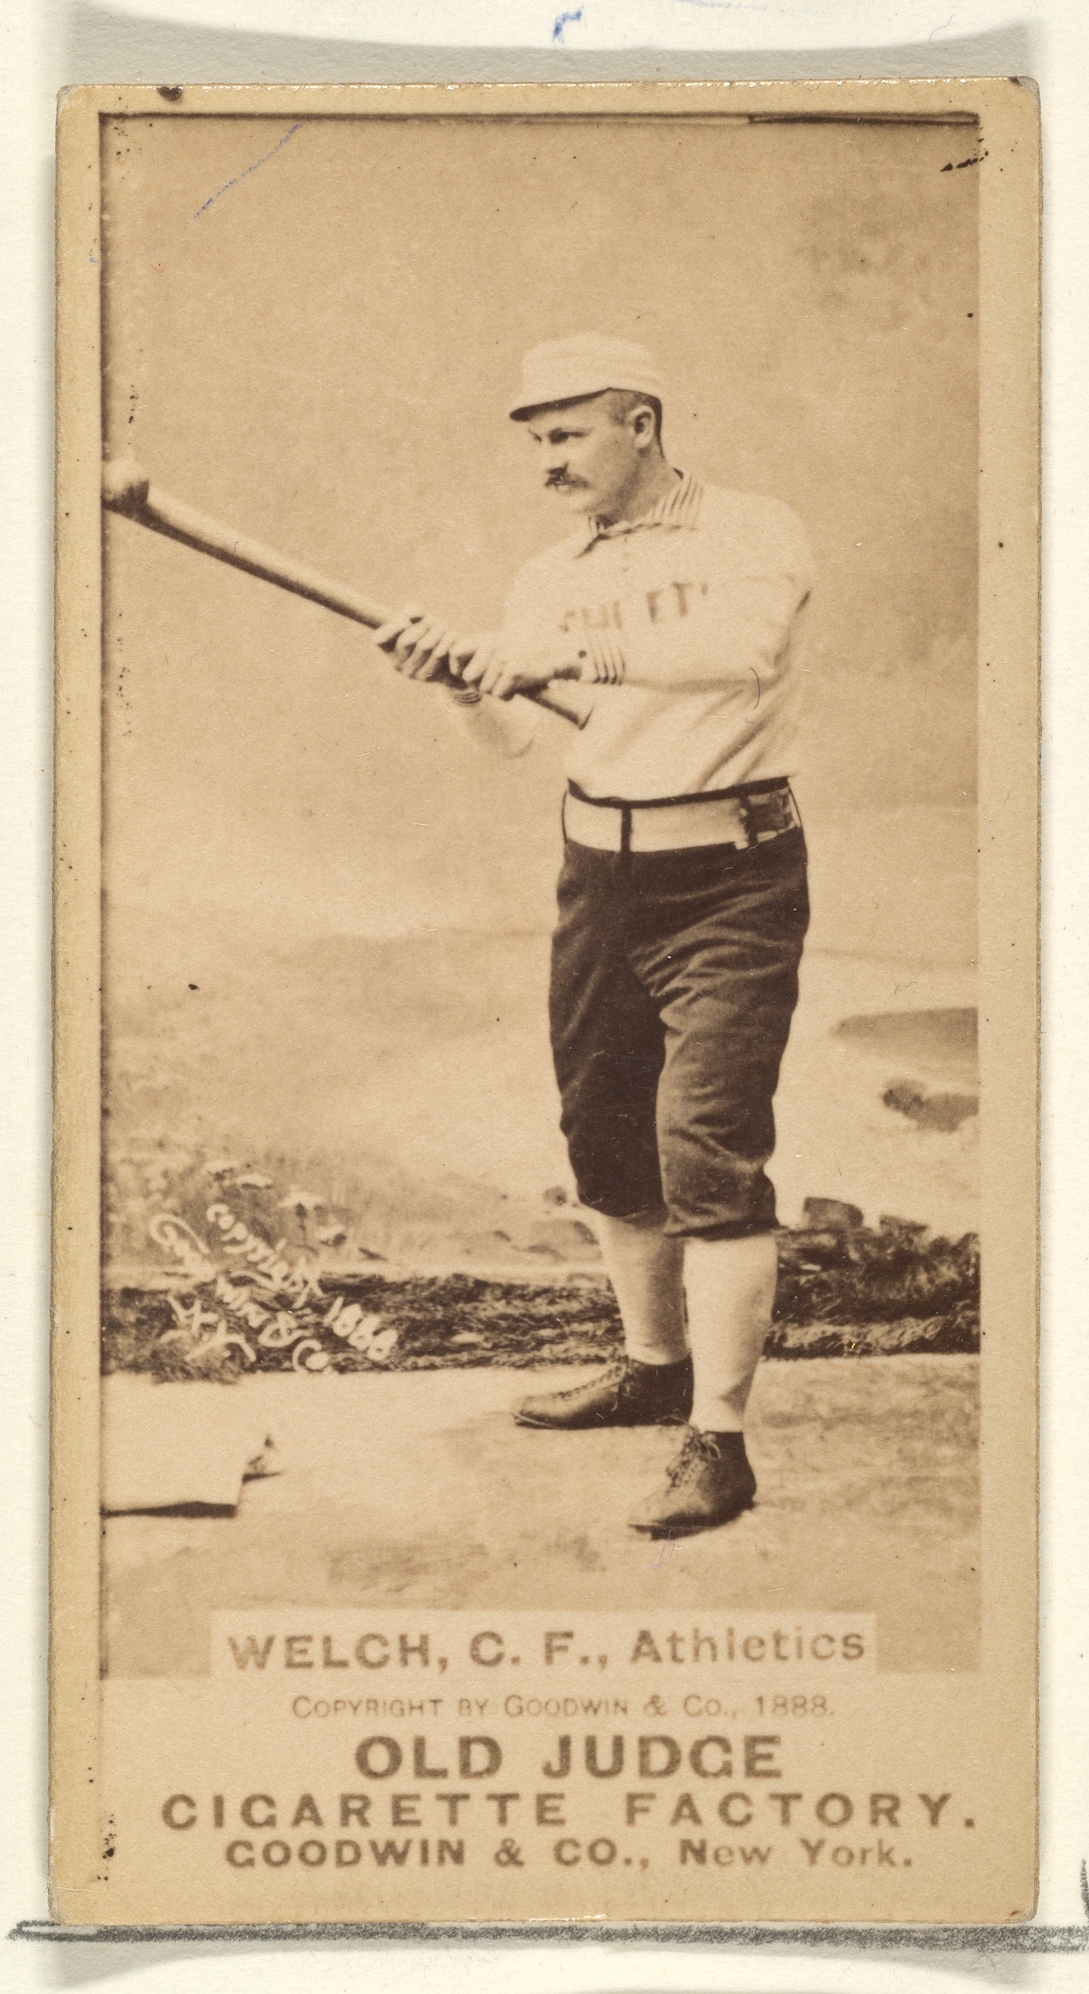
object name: baseball card, photograph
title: Welch, Center Field, Philadelphia Athletics, from the Old Judge series (N172) for Old Judge Cigarettes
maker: goodwin & company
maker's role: publisher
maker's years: 1850-1950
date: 1888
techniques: albumen silver print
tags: men,profiles,baseball,athletes